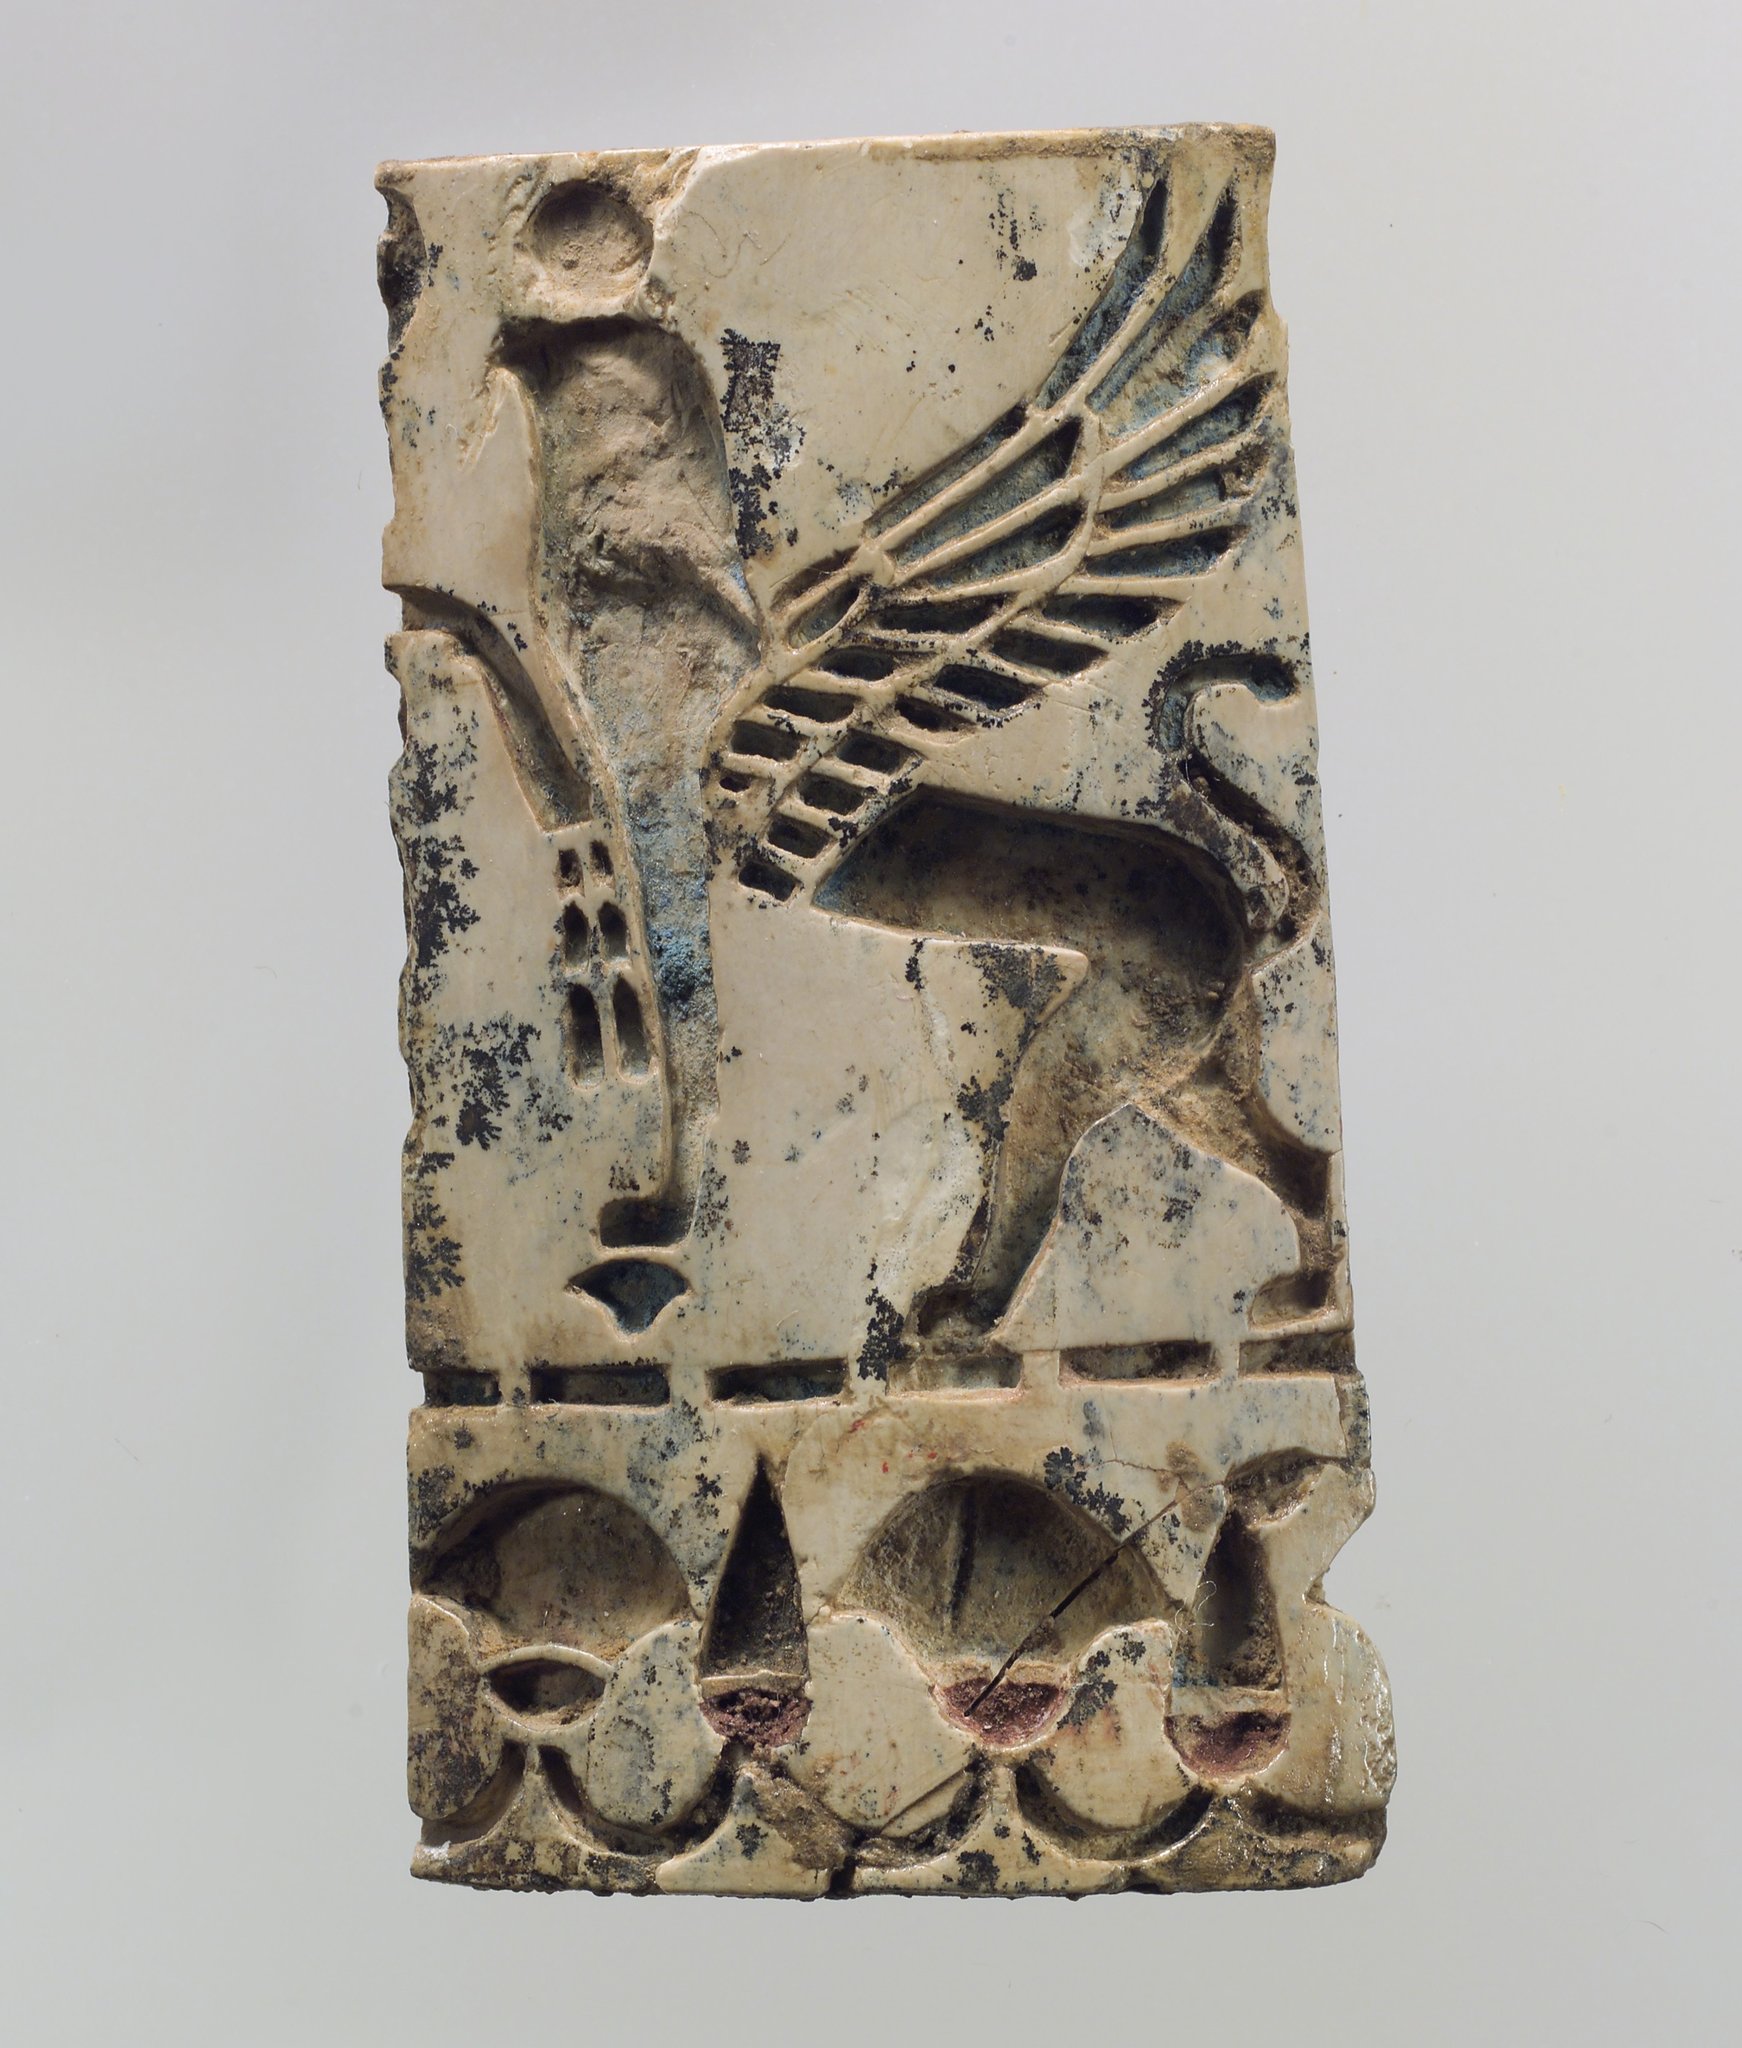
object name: relief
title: Champlevé furniture or cosmetic box plaque with a griffin and a floral frieze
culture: assyrian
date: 900-701 BCE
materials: ivory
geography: mesopotamia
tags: griffins